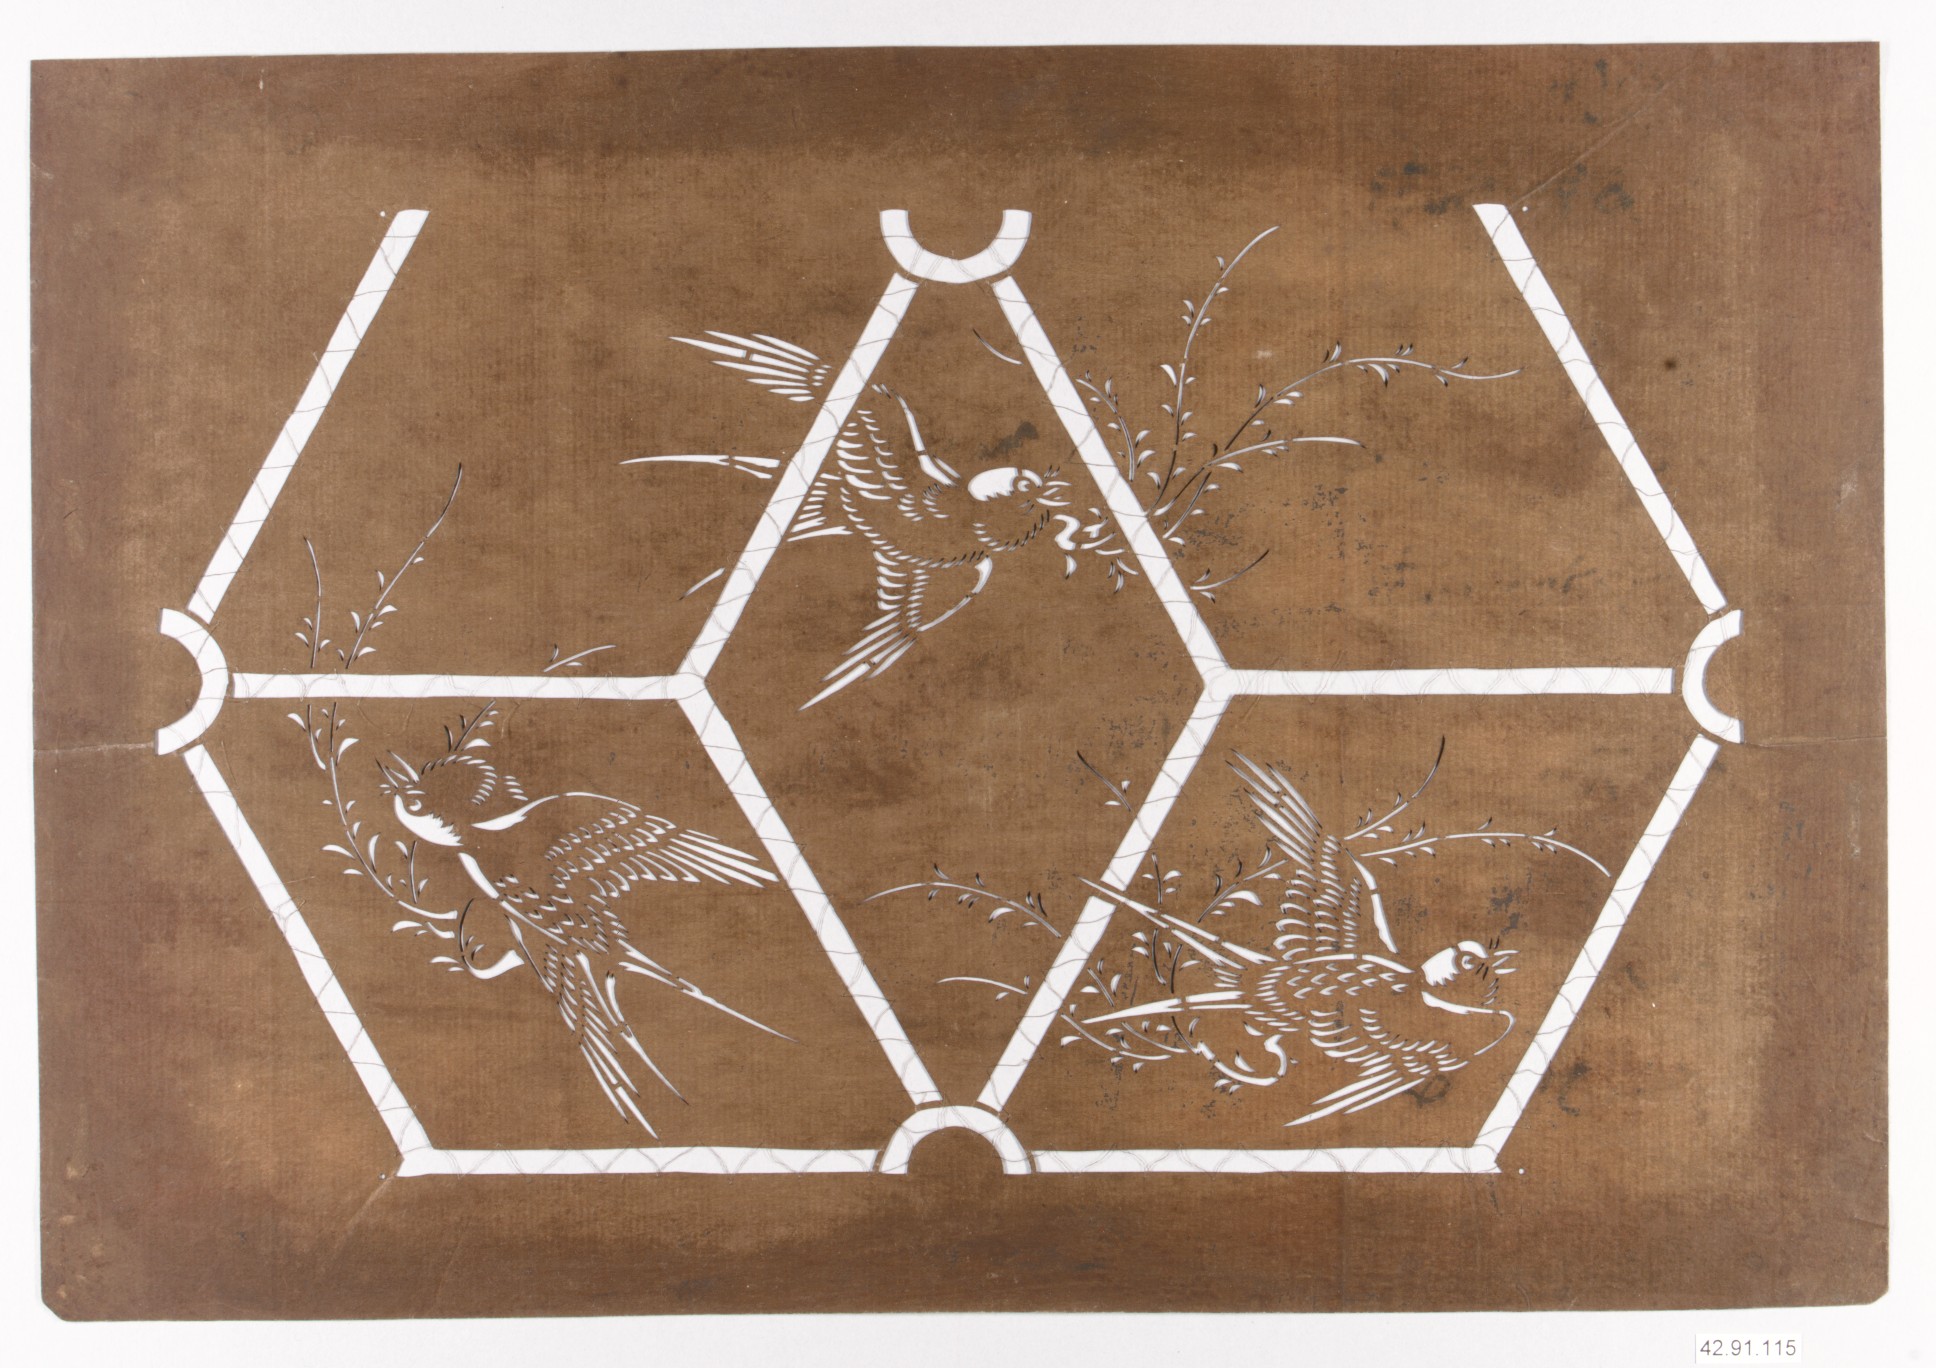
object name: stencil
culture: japanese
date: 1801-1900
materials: paper, silk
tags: birds